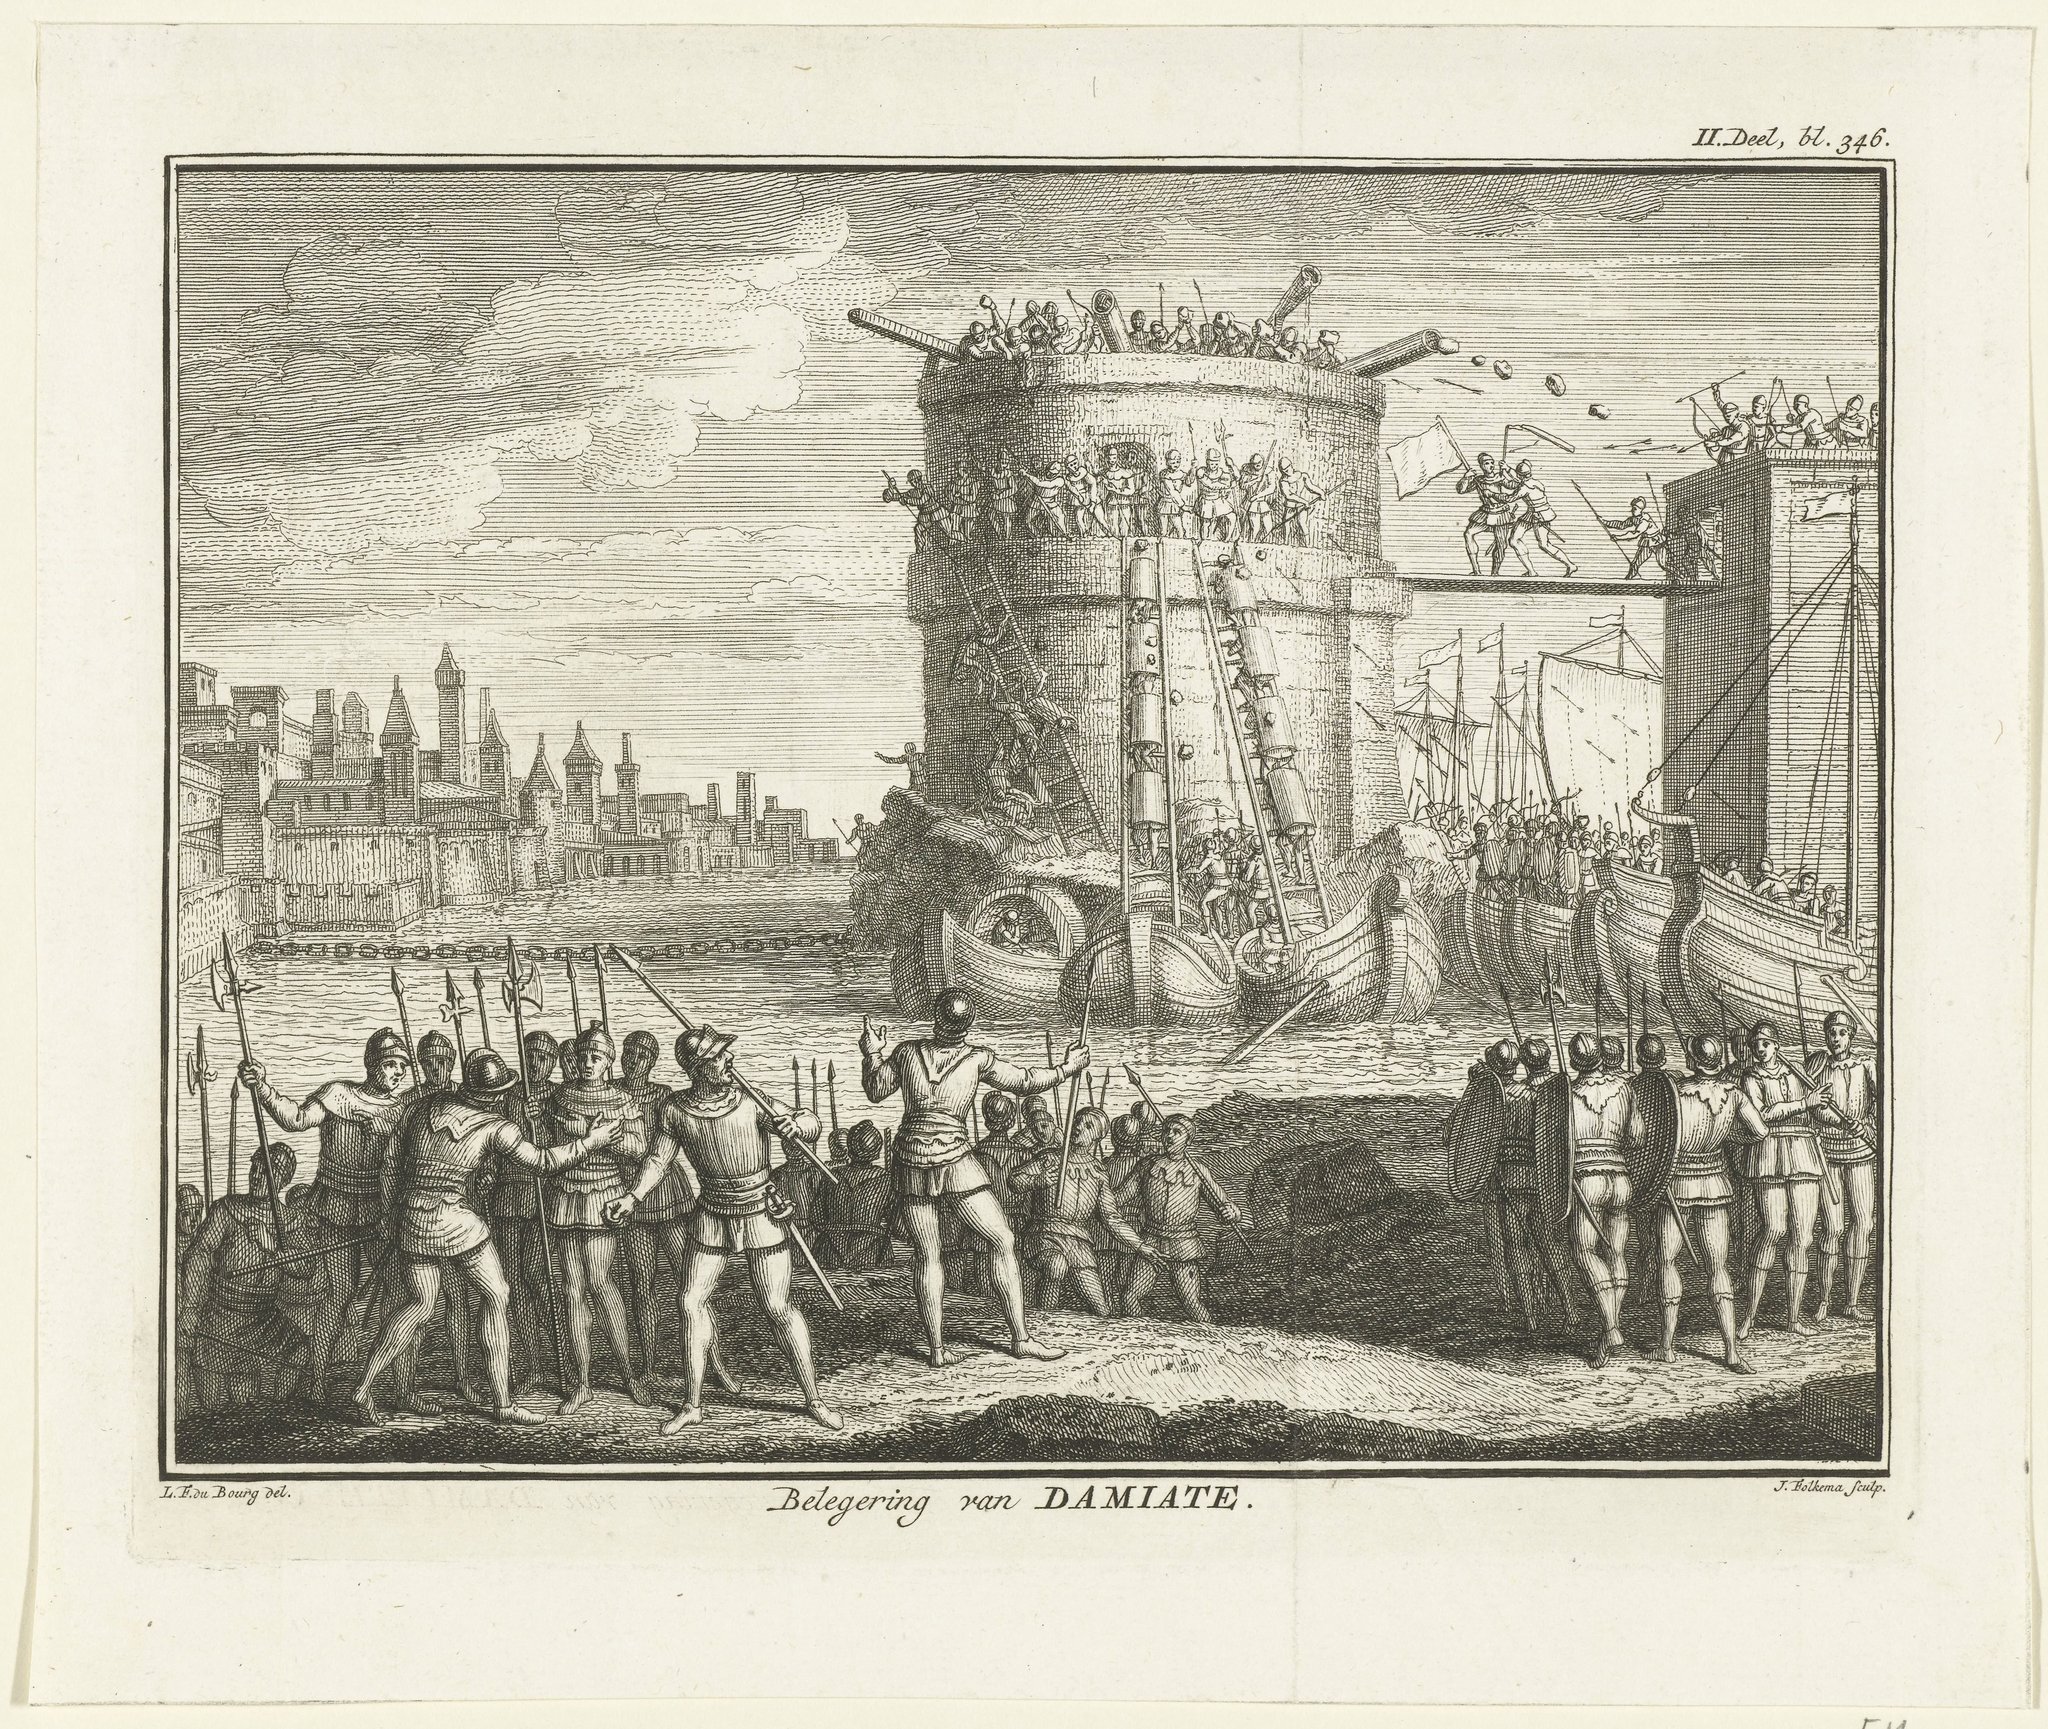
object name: history print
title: Belegering van Damiate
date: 1747-1759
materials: paper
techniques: etching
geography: northern netherlands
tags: siege, position war, haarlem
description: Het beleg van de stad Damiate, 1219. Toren bij de met de ketting afgesloten haven wordt aangevallen door soldaten vanuit schepen.